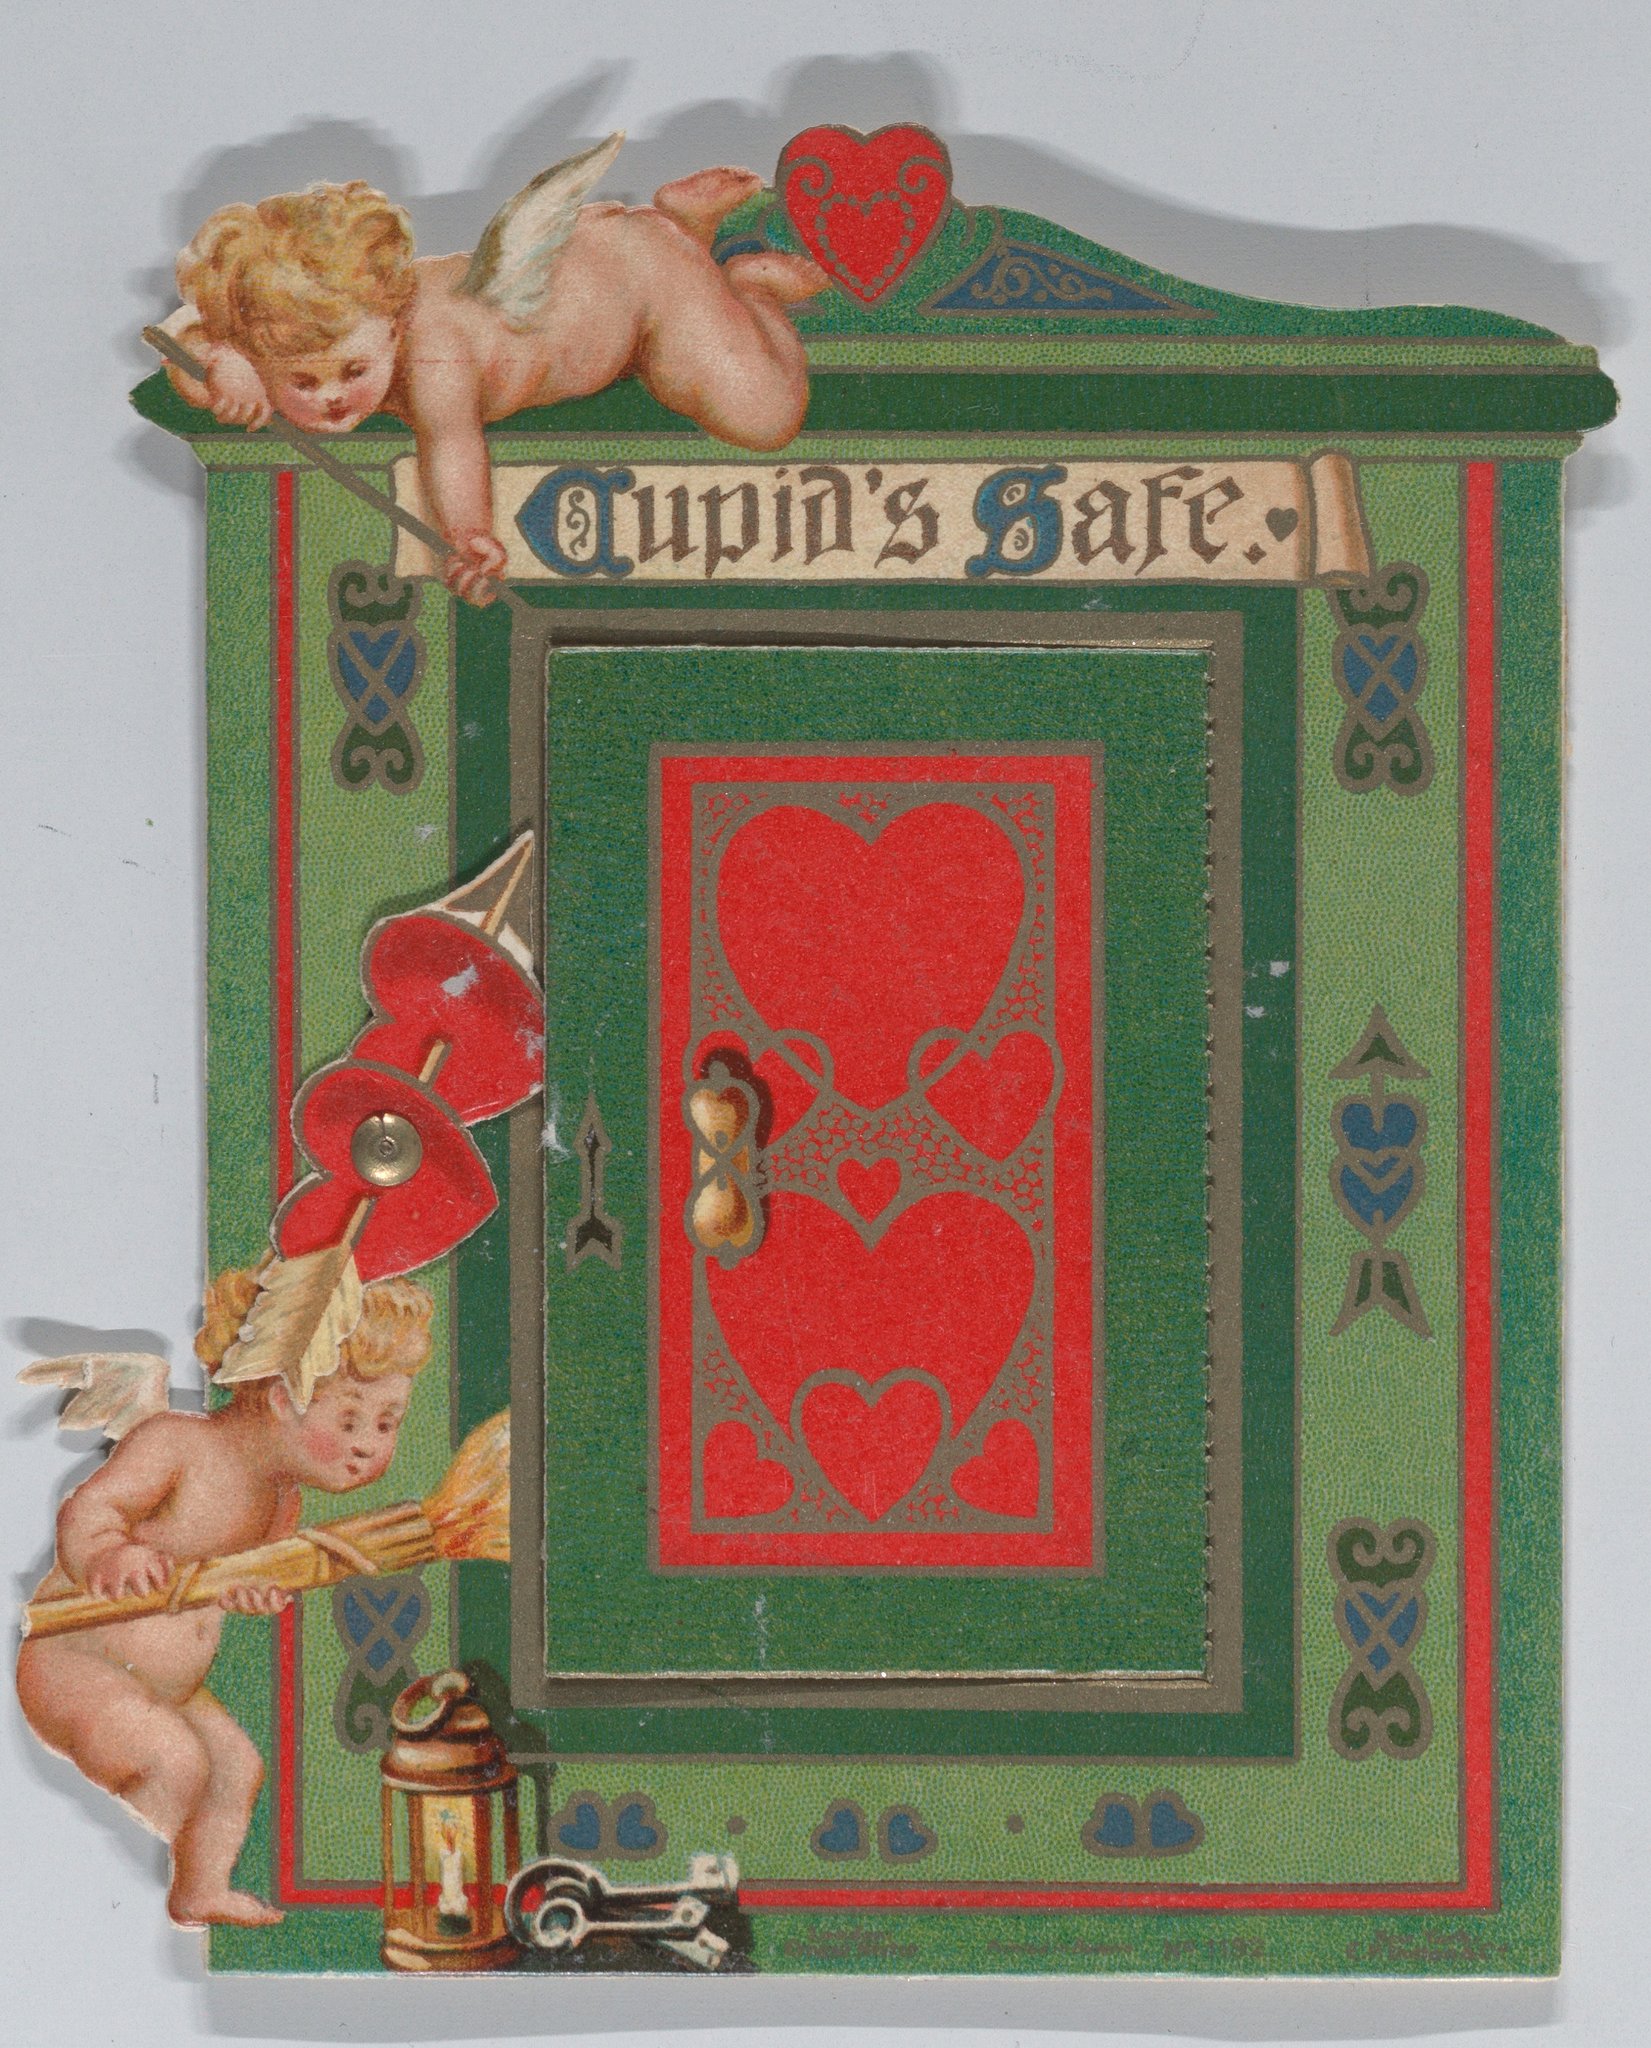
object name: valentine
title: Valentine - Mechanical, Cupids with safe and money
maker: anonymous, british or american, 19th century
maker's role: artist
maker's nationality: british or american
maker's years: 1800-1900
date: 1875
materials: brass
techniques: chromolithography